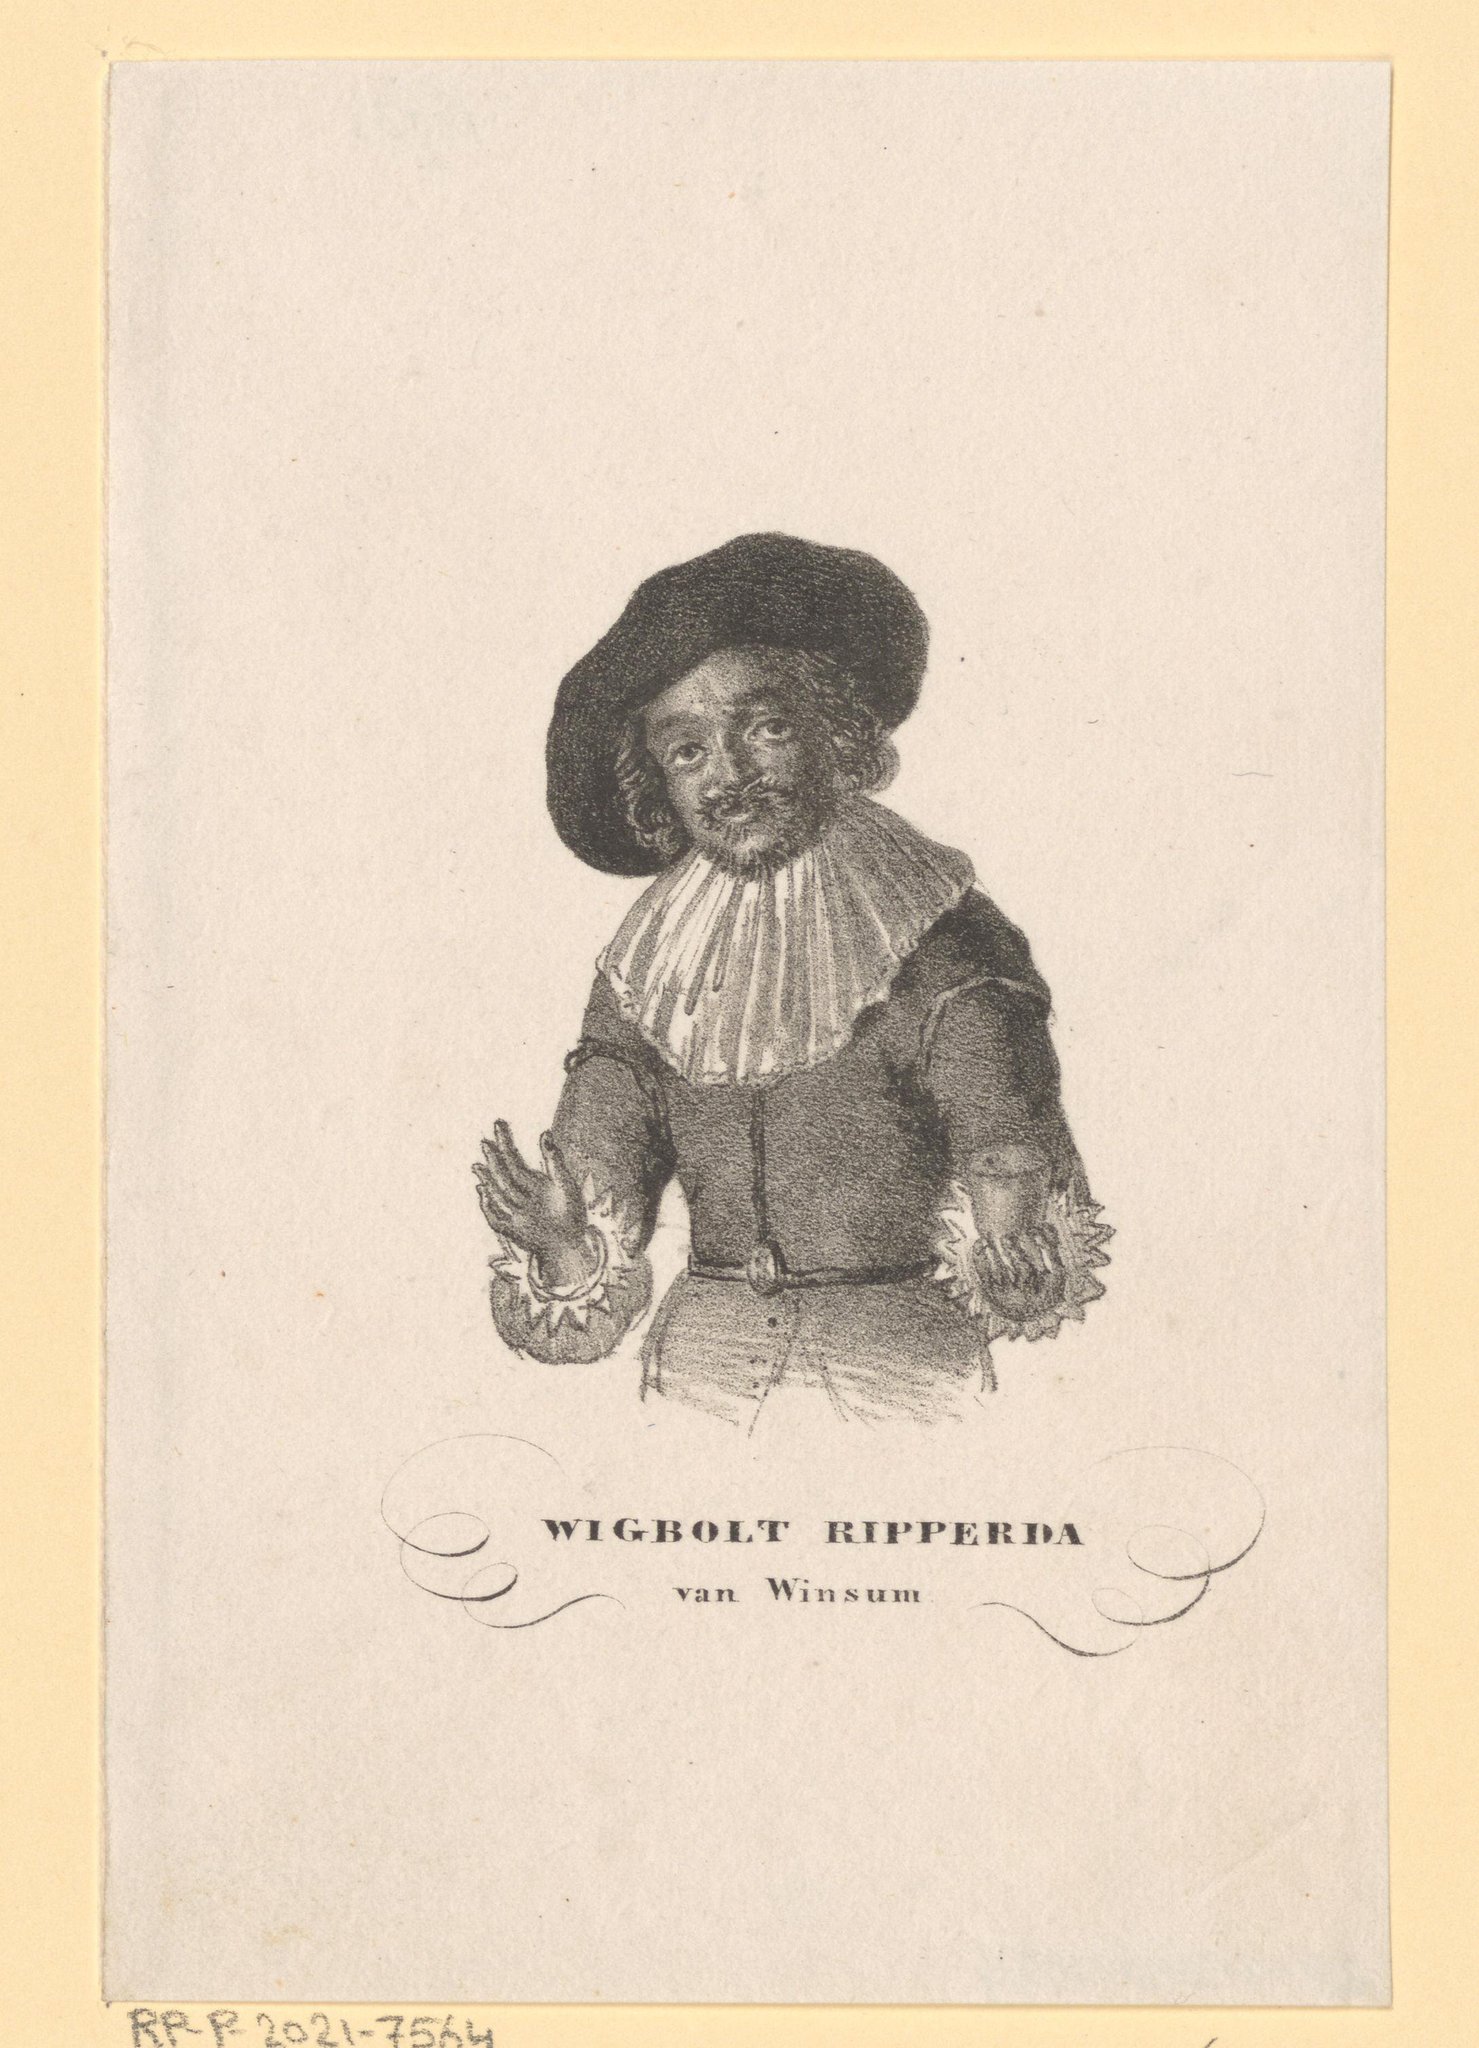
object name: print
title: Portret van Wigbolt Ripperda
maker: Anonymous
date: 1795-1899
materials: paper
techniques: lithograph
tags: historical persons